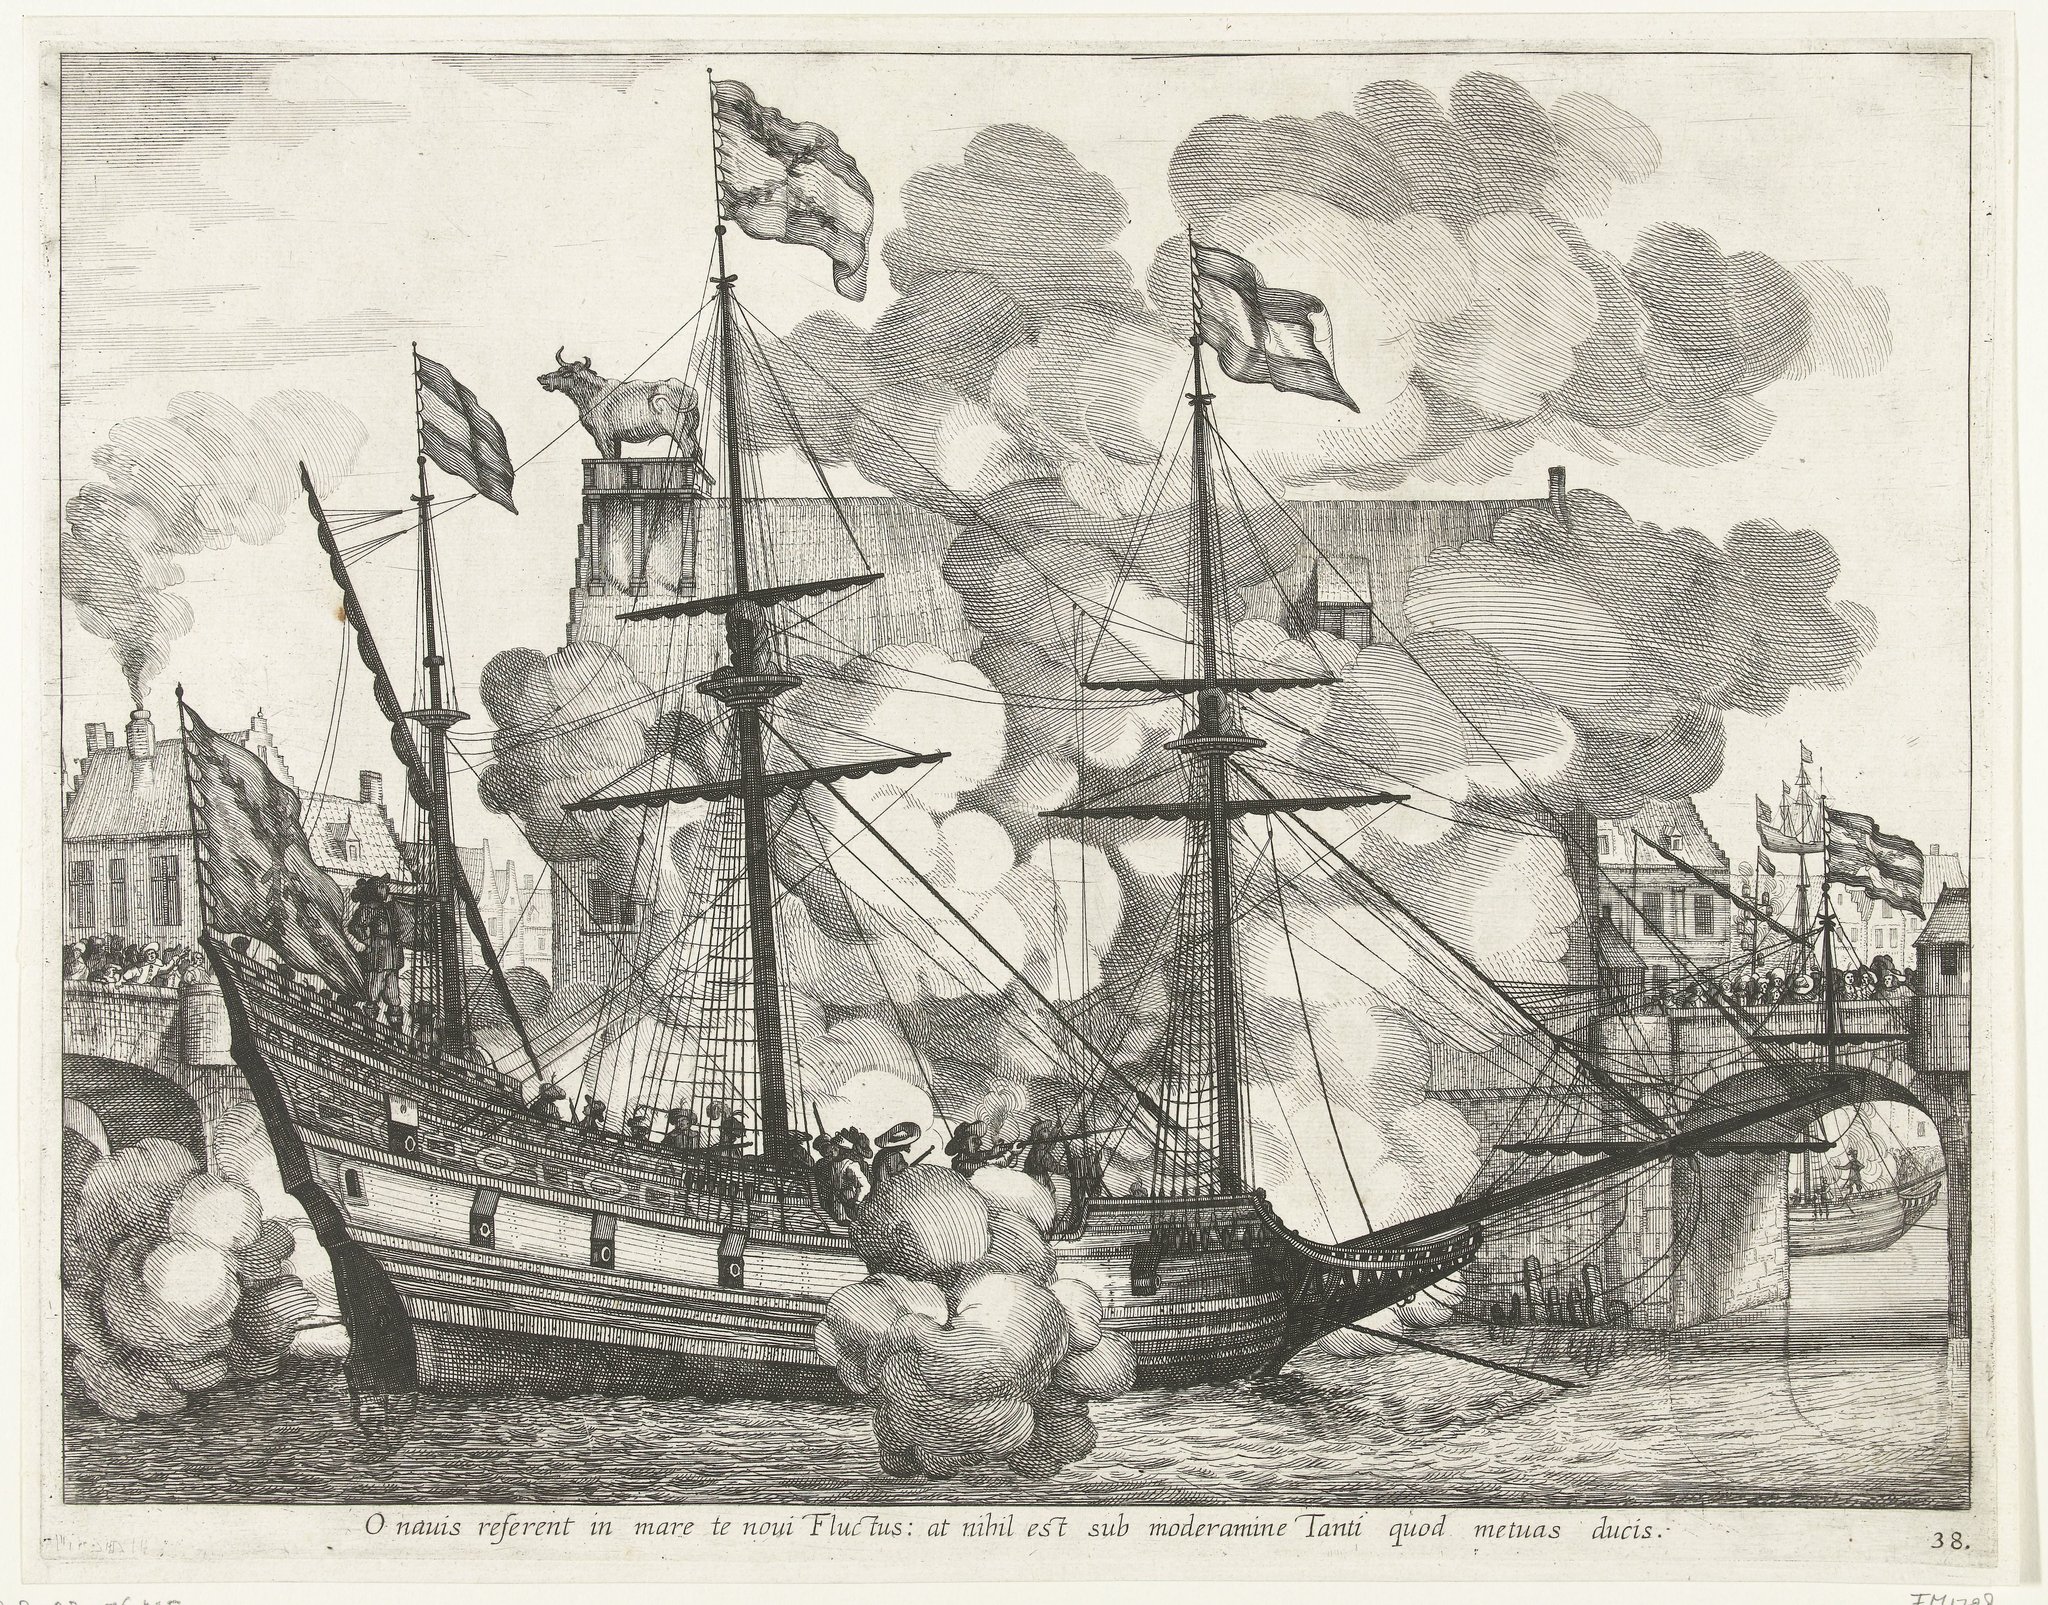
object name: print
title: O navis referent in mare te novi Fluctus: at nihil est sub moderamine Tanti quod metuas ducis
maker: Anonymous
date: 1635-1636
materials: paper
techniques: engraving, etching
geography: southern netherlands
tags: landvoogd der zuidelijke nederlanden ferdinand van oostenrijk, ships (in general) (+ propulsion of vehicle, ship, etc. by wind), triumphal entry and public reception, pageant, 'entrée solennelle', 'joyeuse entrée', ghent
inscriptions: collector's mark: Lugt 240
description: Zeilschip die de veiligheid ter zee symboliseert aan een kade te Gent. Op de kades veel toeschouwers. Blad nr. 38 in een geheel van 42 platen die de uitgave van de beschrijving van de intocht van de Kardinaal Infant Ferdinand van Oostenrijk te Gent op 28 januari 1635 als de nieuwe landvoogd voor de Spaanse Nederlanden illustreren.